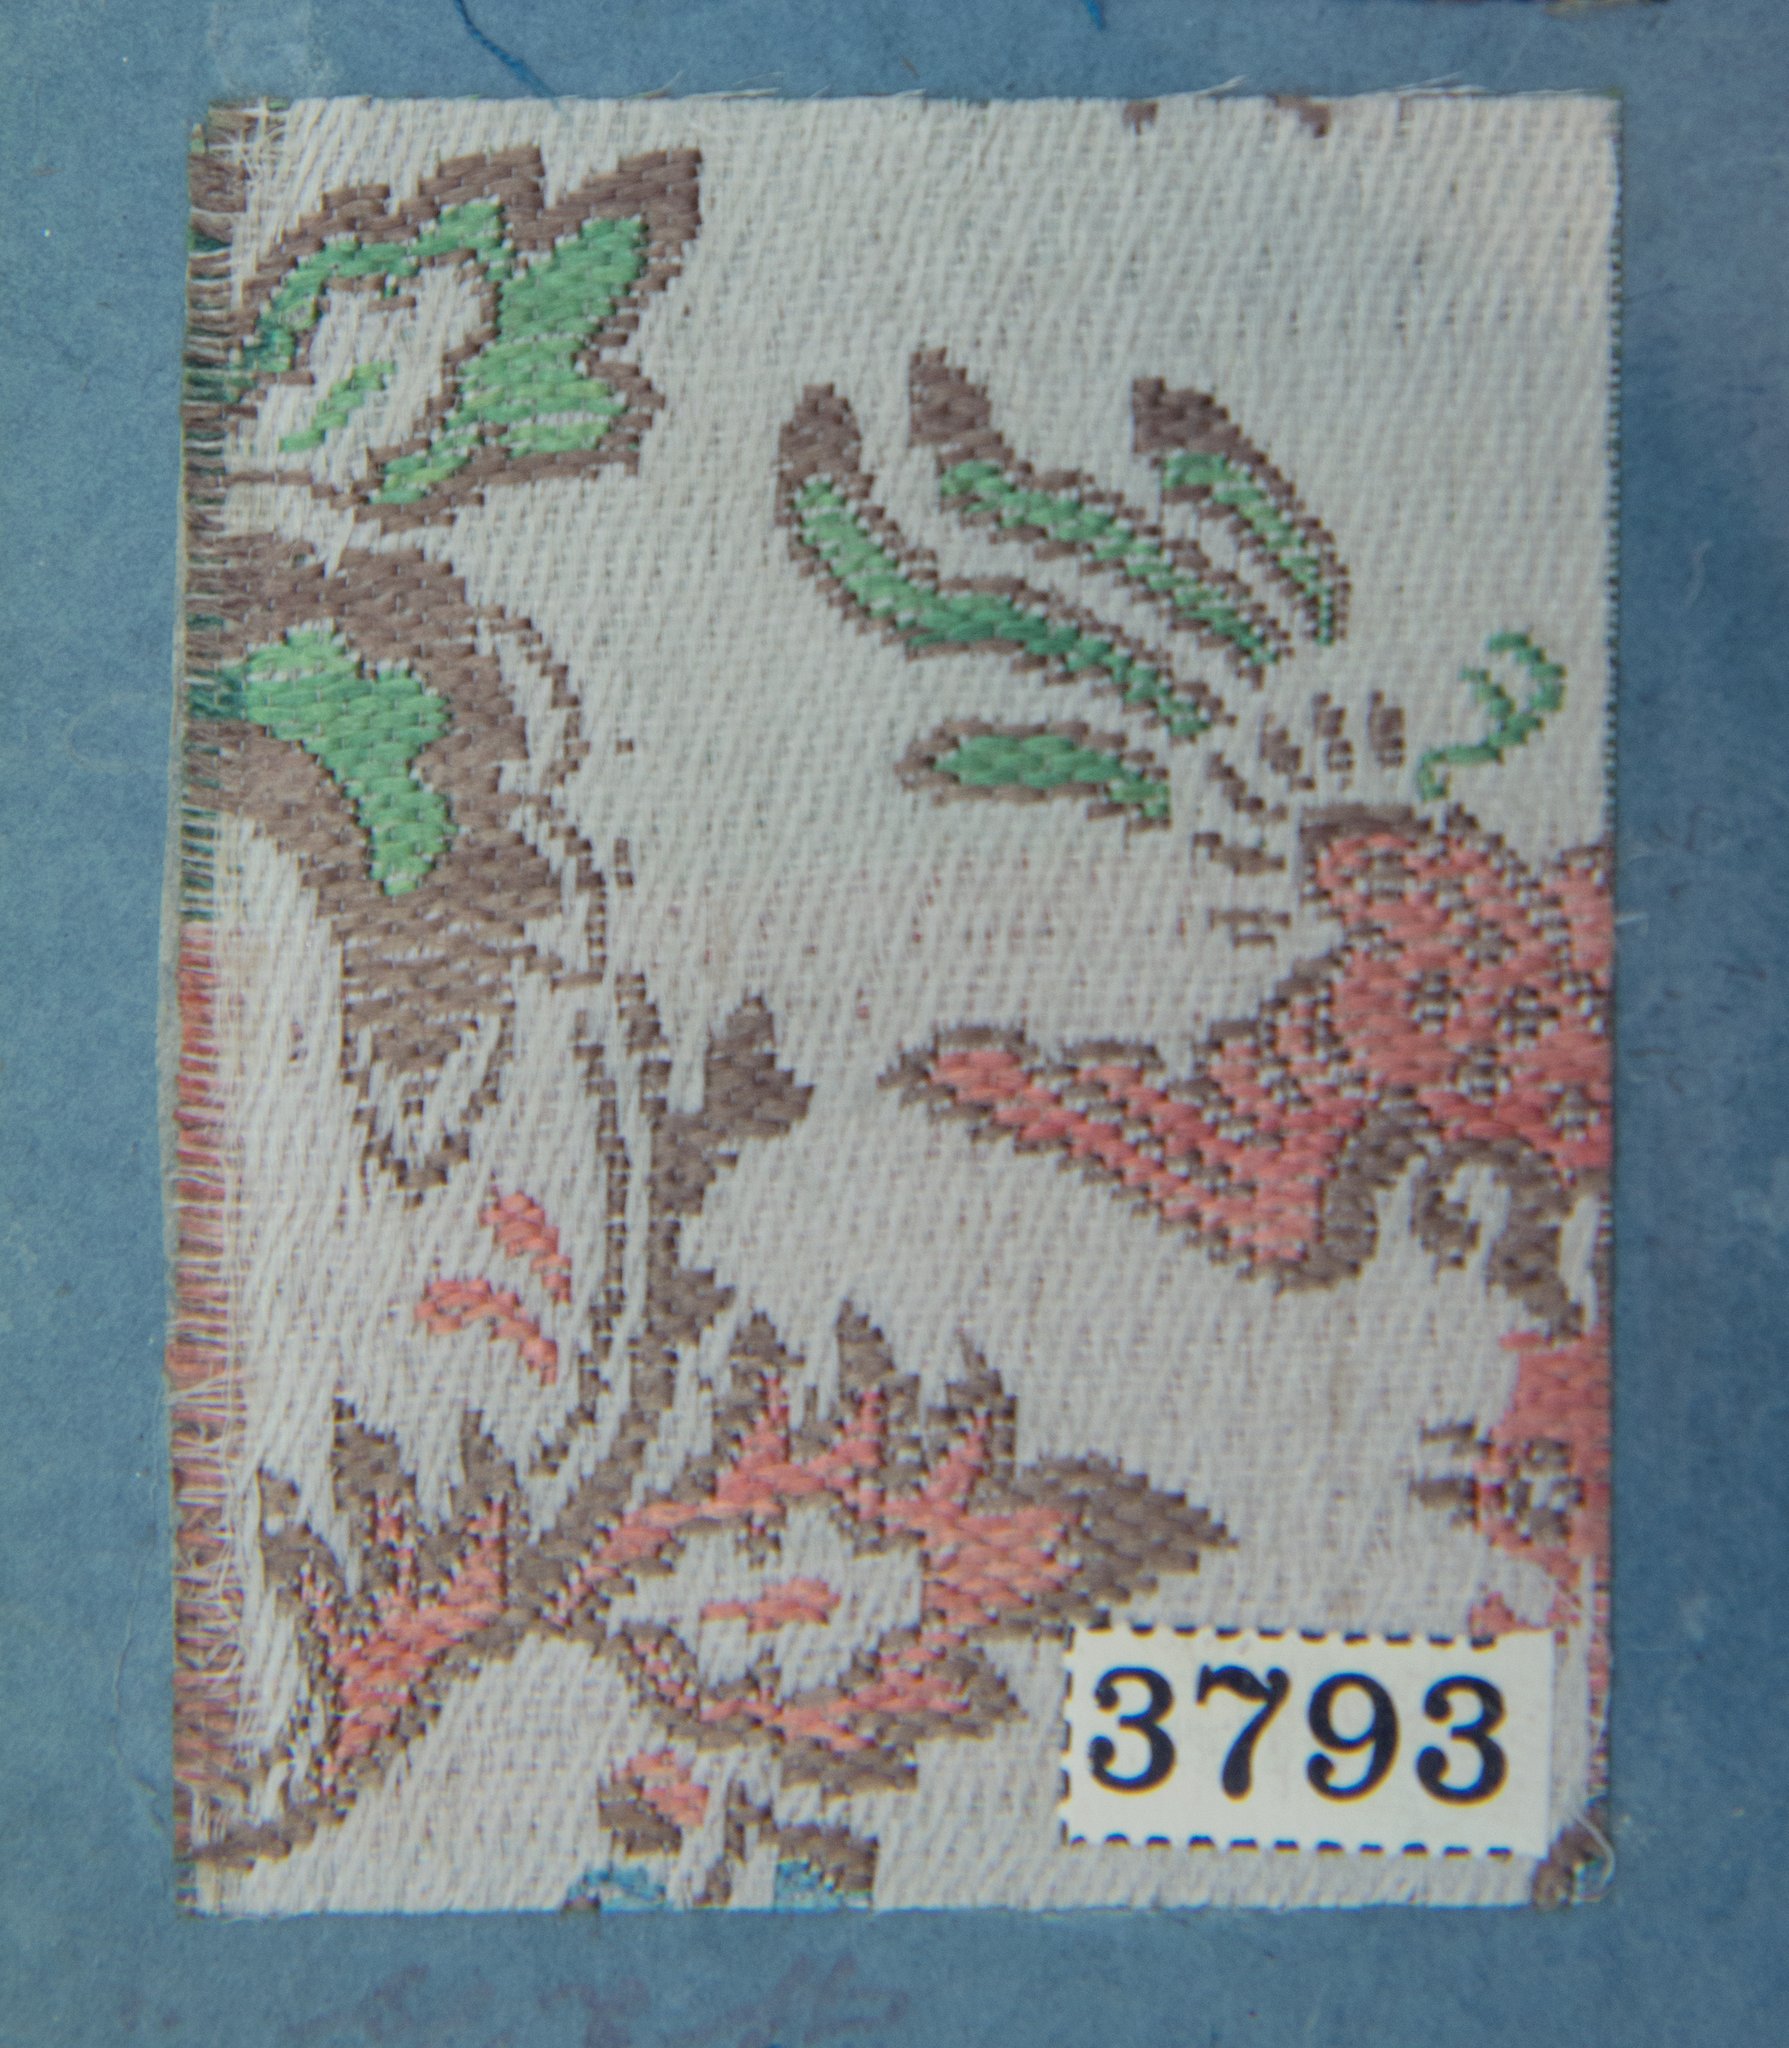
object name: sample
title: Textile Sample from Sample Book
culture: japanese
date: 1801-1900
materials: silk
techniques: tapestry